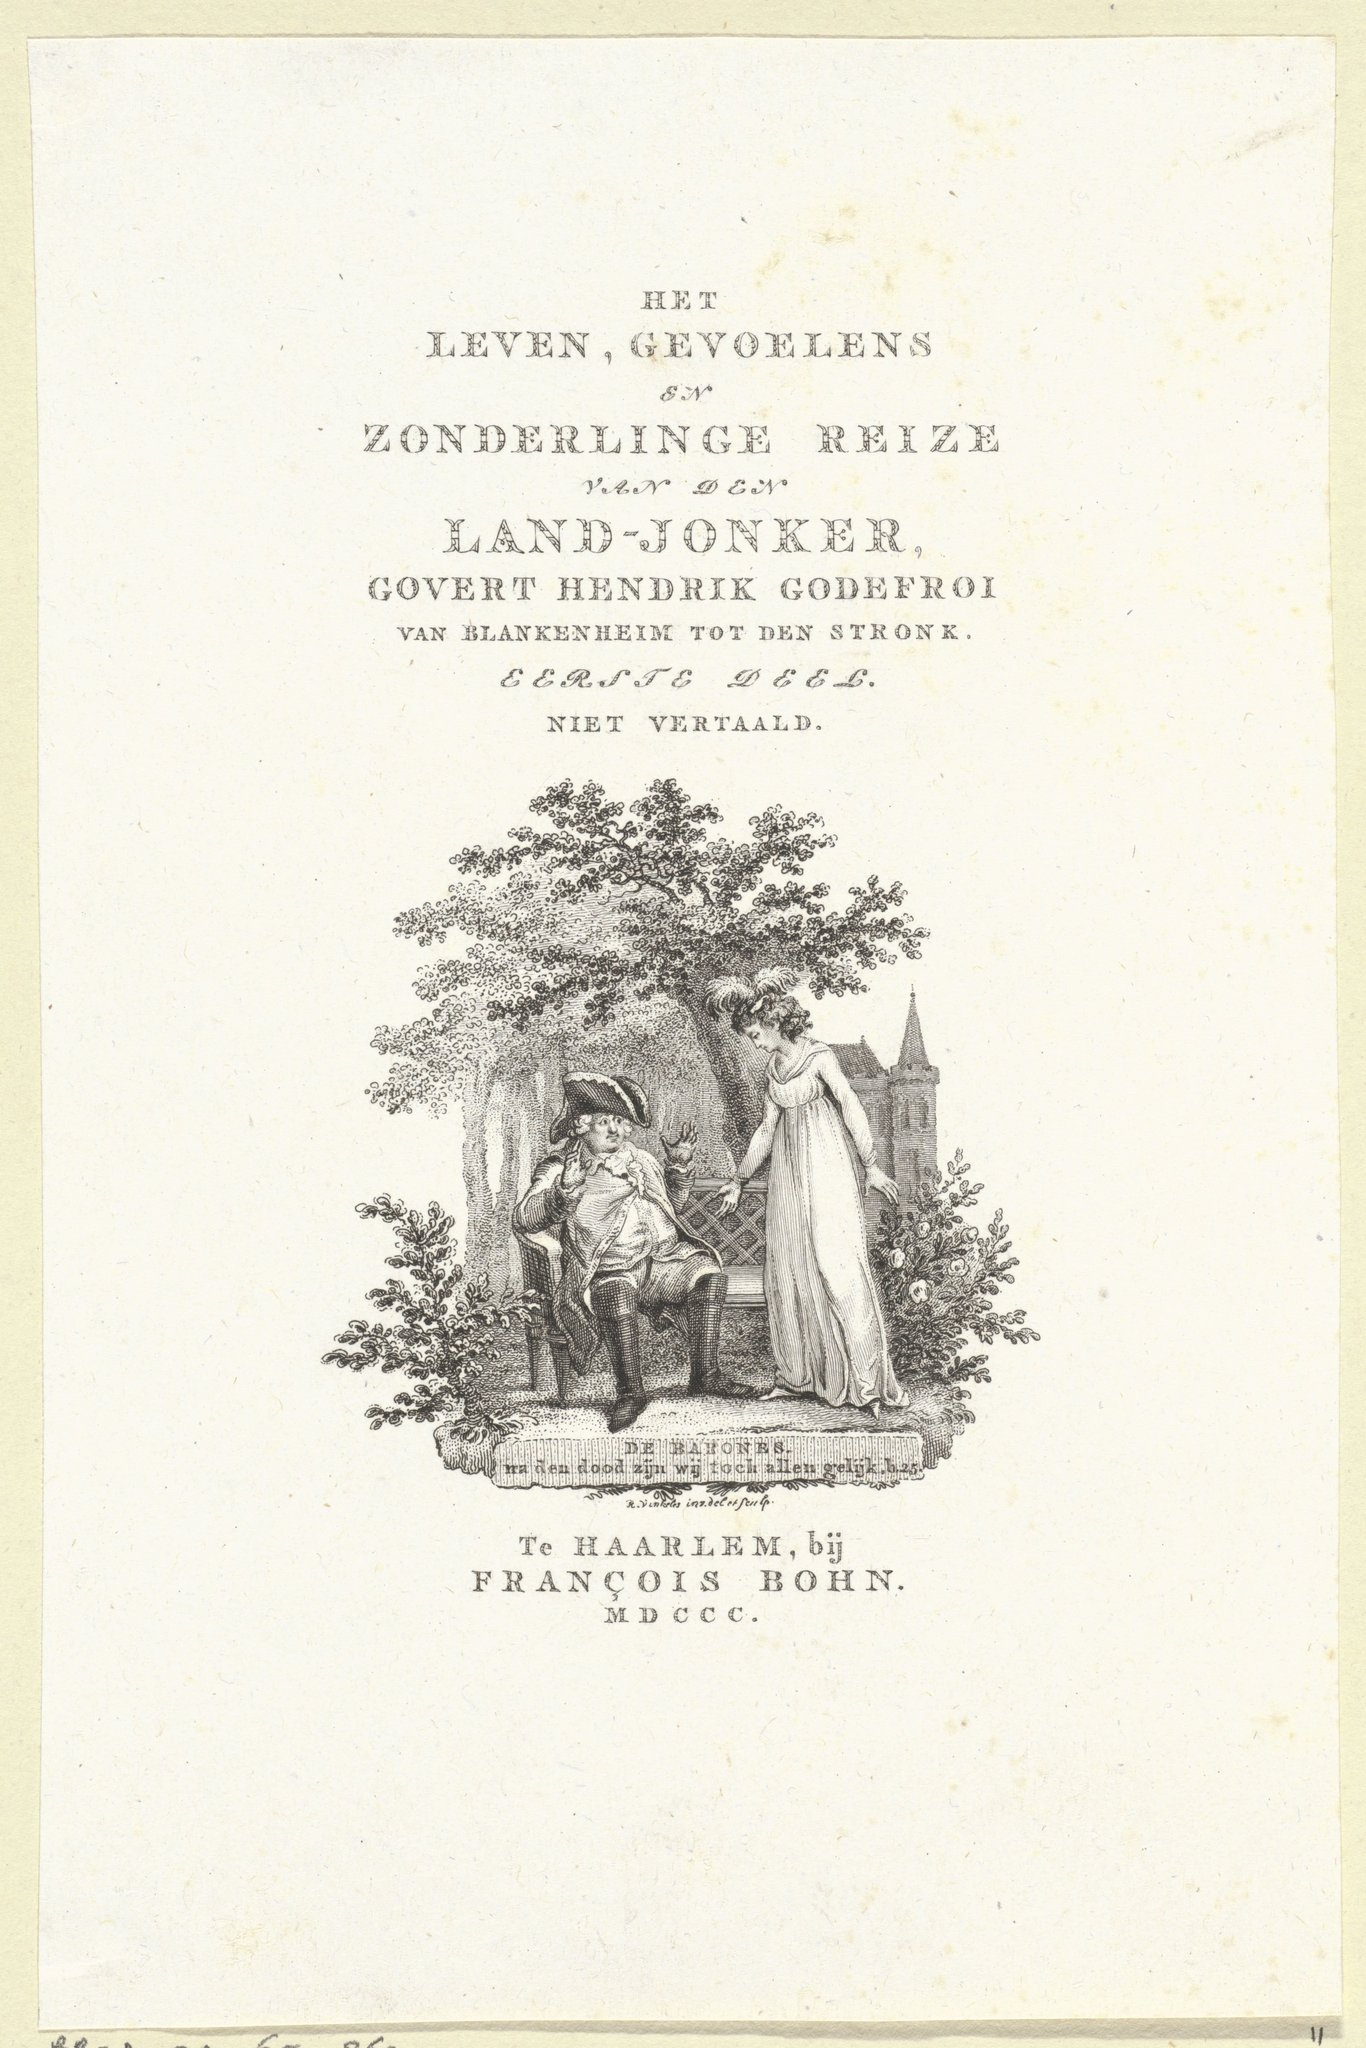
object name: print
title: Titelpagina voor: W. Kist 'Het Leven, Gevoelens en Zonderlinge Reize van den Land-Jonker Govert Hendrik Godefroi van Blankenheim tot den Stronk', 1800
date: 1800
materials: paper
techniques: engraving, etching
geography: haarlem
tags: castle, couch, sofa, settee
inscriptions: collector's mark: Lugt 240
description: Proefdruk van titelpagina voor: Kist, Wilhelmus. Het leven, gevoelens en zonderlinge reize van den land-jonker Govert Hendrik Godefroi van Blankenheim tot den Stronk. Haarlem: François Bohn, 1800.